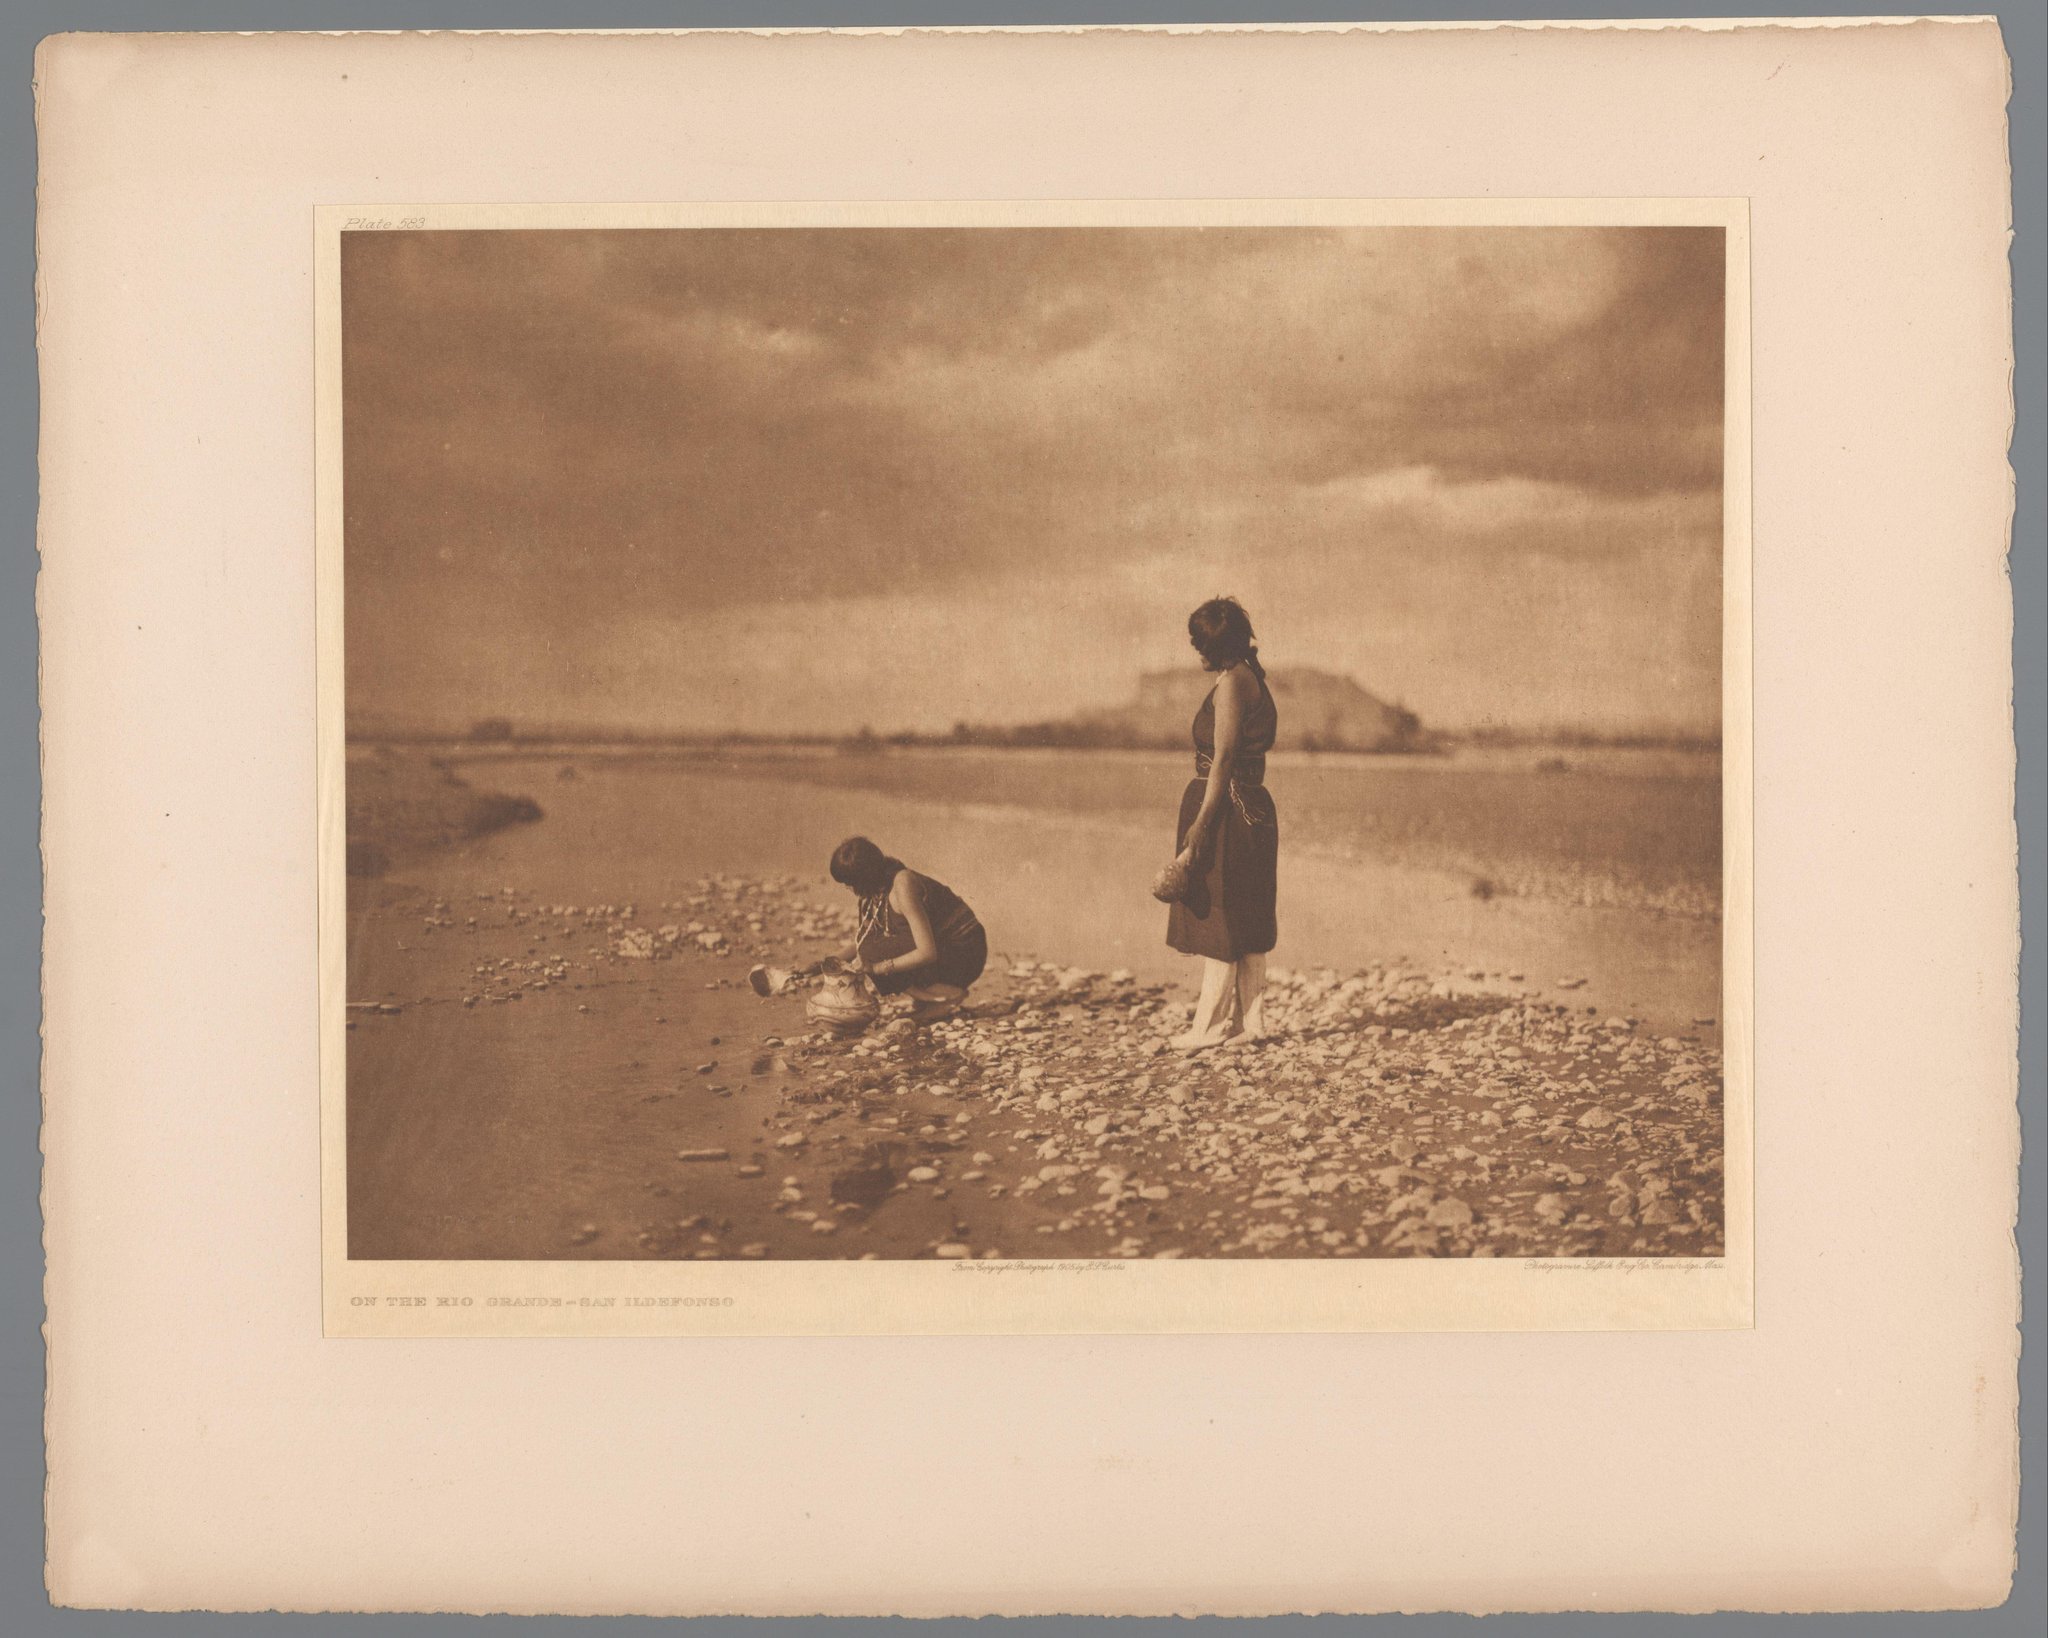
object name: photograph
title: On the Rio Grande- San Ildefonso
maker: edward sheriff curtis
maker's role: fotograaf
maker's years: 1868-1952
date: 1900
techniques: photoaquatint